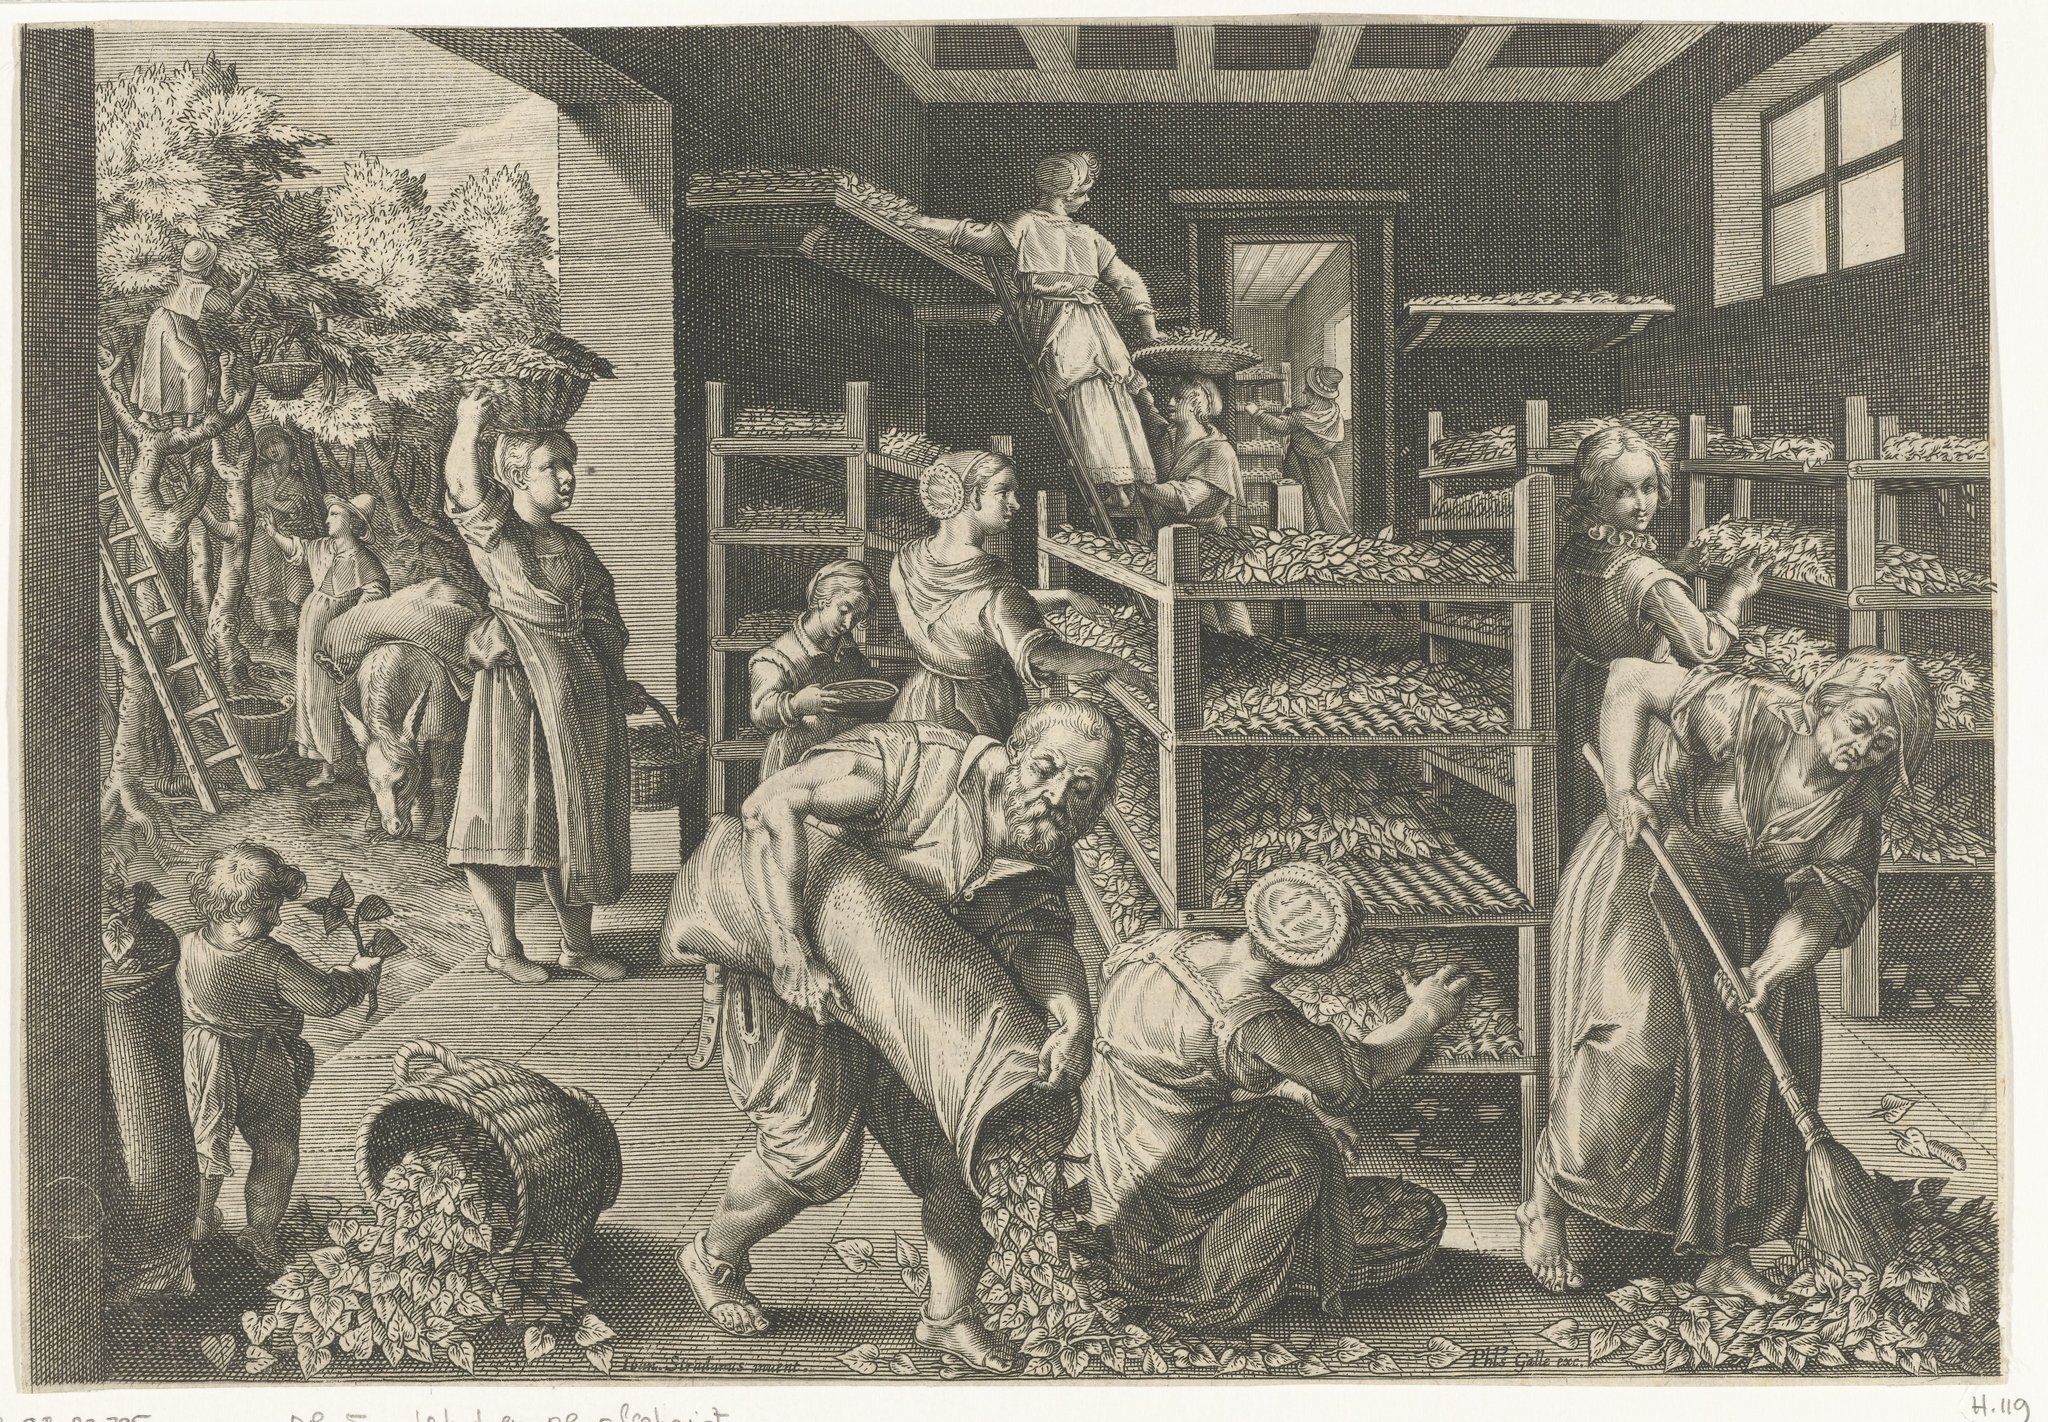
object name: print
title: Vermis Sericus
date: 1595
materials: paper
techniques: engraving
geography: antwerp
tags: special processes for silk fabric, silkworm, silk (material ~ textile industry)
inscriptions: collector's mark: Lugt 240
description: In een interieur worden de zijderupsen gevoerd met de bladeren van de Moerbeiboom. Links een doorkijk naar buiten, waar de bladeren worden verzameld. Vijfde prent van een serie van zes prenten over de introductie van de zijderups en de zijdeproductie in Europa.